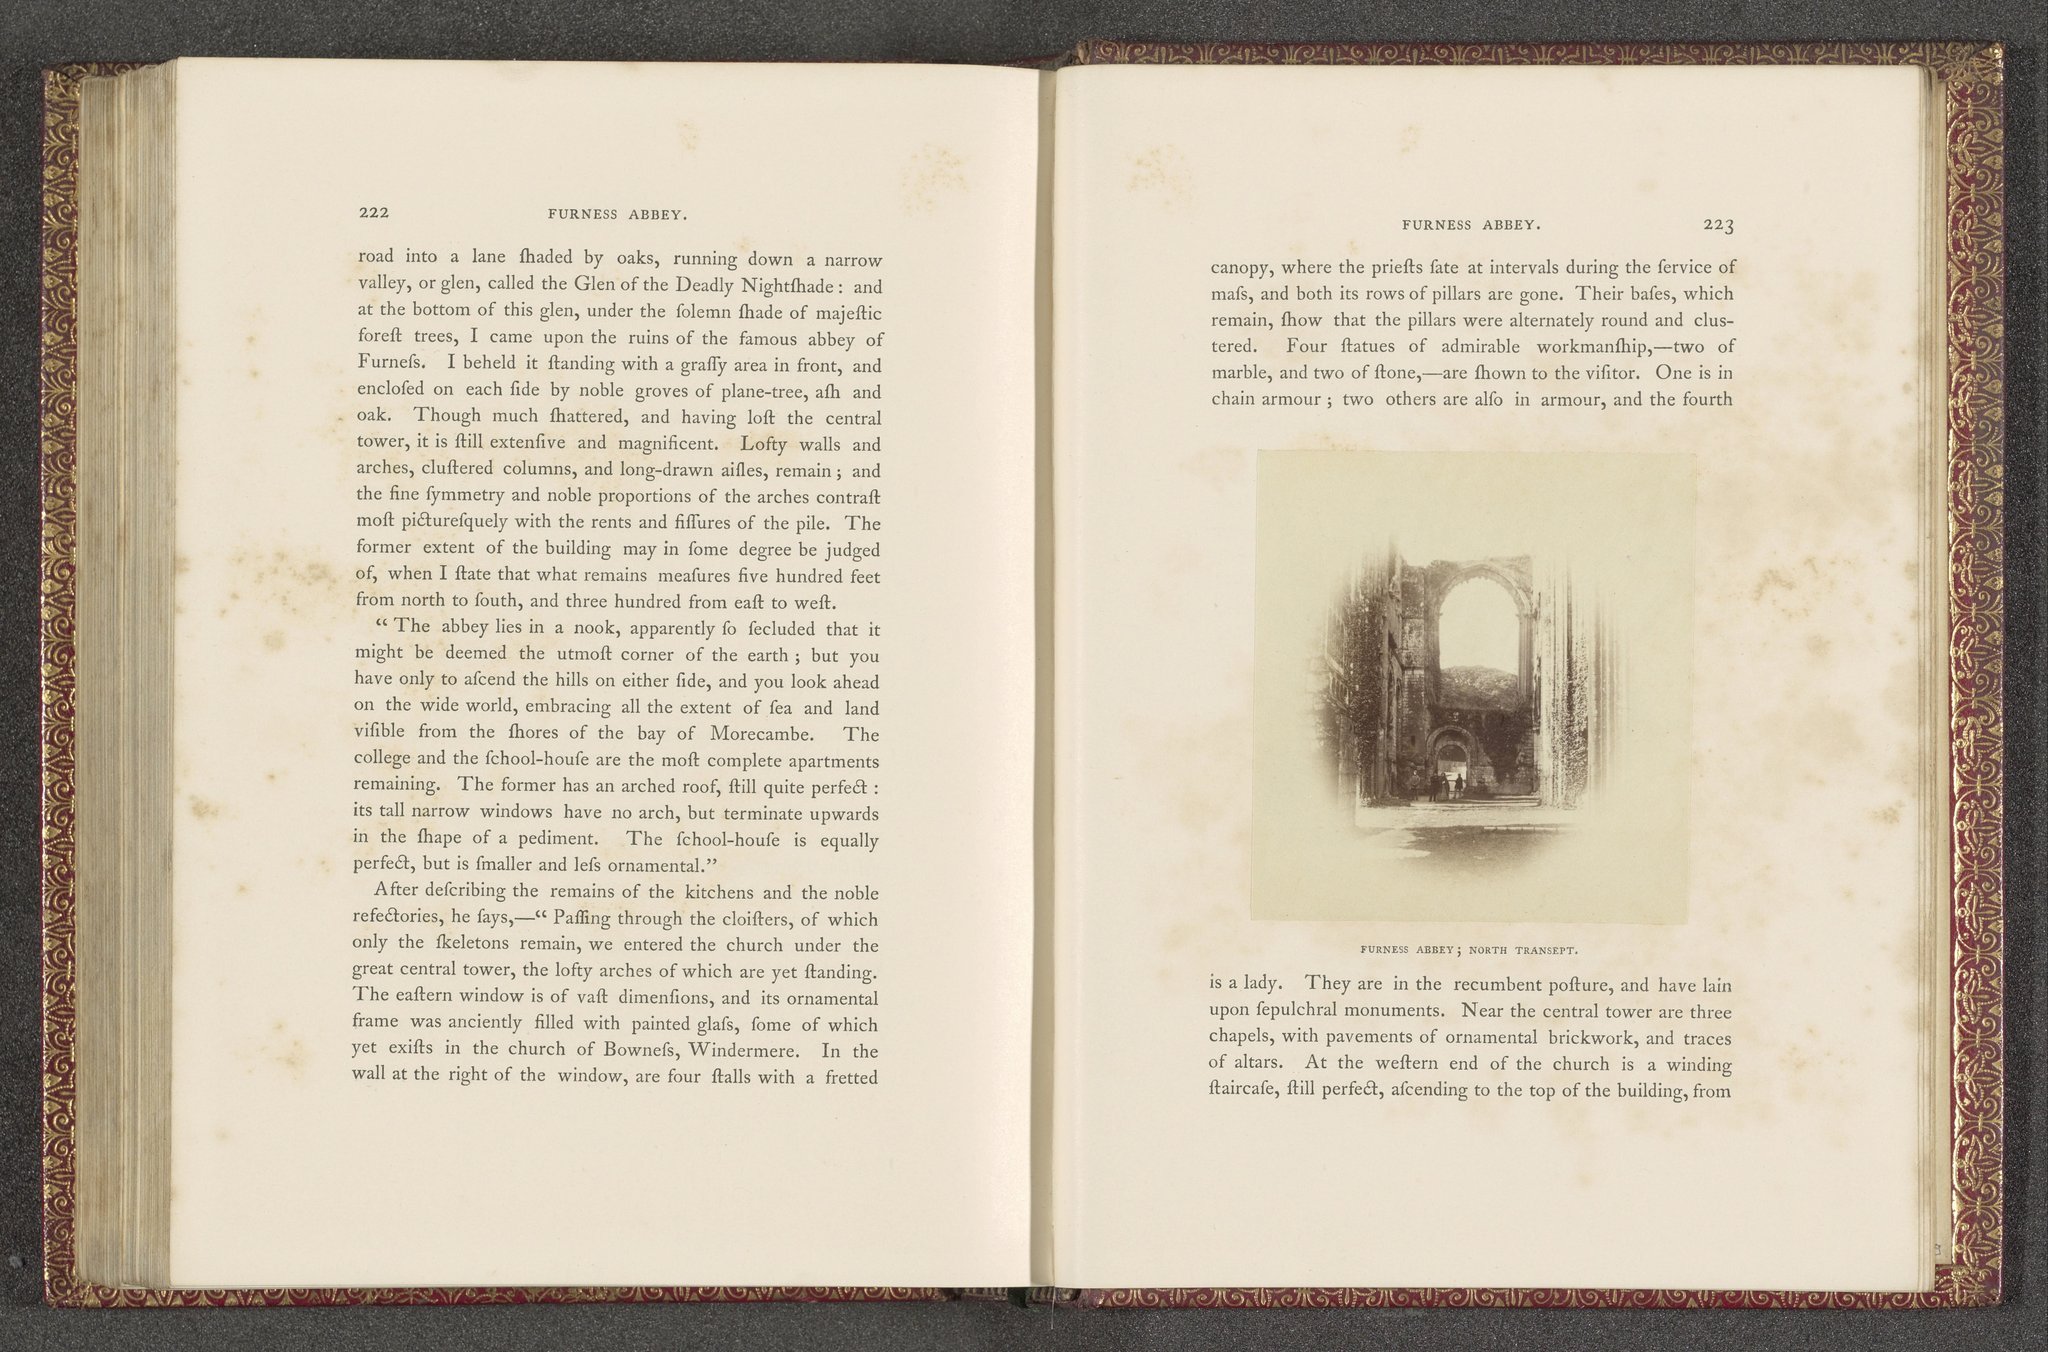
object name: page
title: Interieur van de ruïne van de Abdij van Furness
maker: roger fenton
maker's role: fotograaf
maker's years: 1819-1869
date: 1852-1862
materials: photographic support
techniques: albumen print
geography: furness abbey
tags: parts of church interior: transept, ruin of church, monastery, etc.